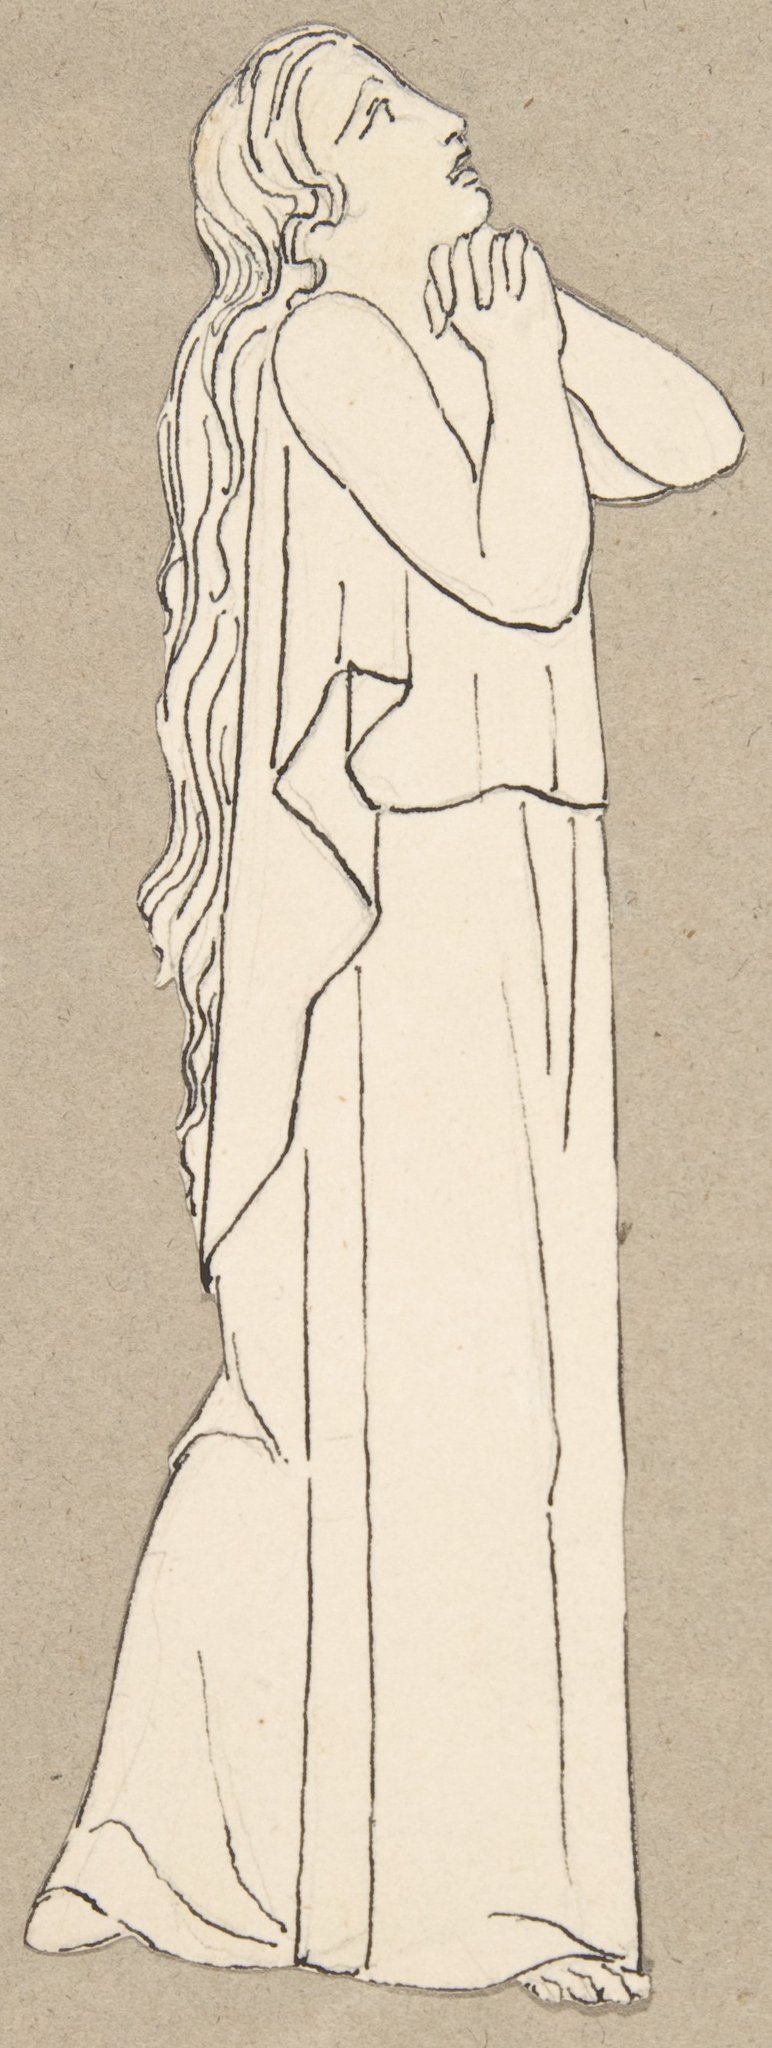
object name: drawing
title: Female classical figure (design for large fireplace white tiles produced in Wedgwood's factory)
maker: john flaxman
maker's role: artist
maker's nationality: british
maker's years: 1755-1826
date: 1801-1900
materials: graphite, ink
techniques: pen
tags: women